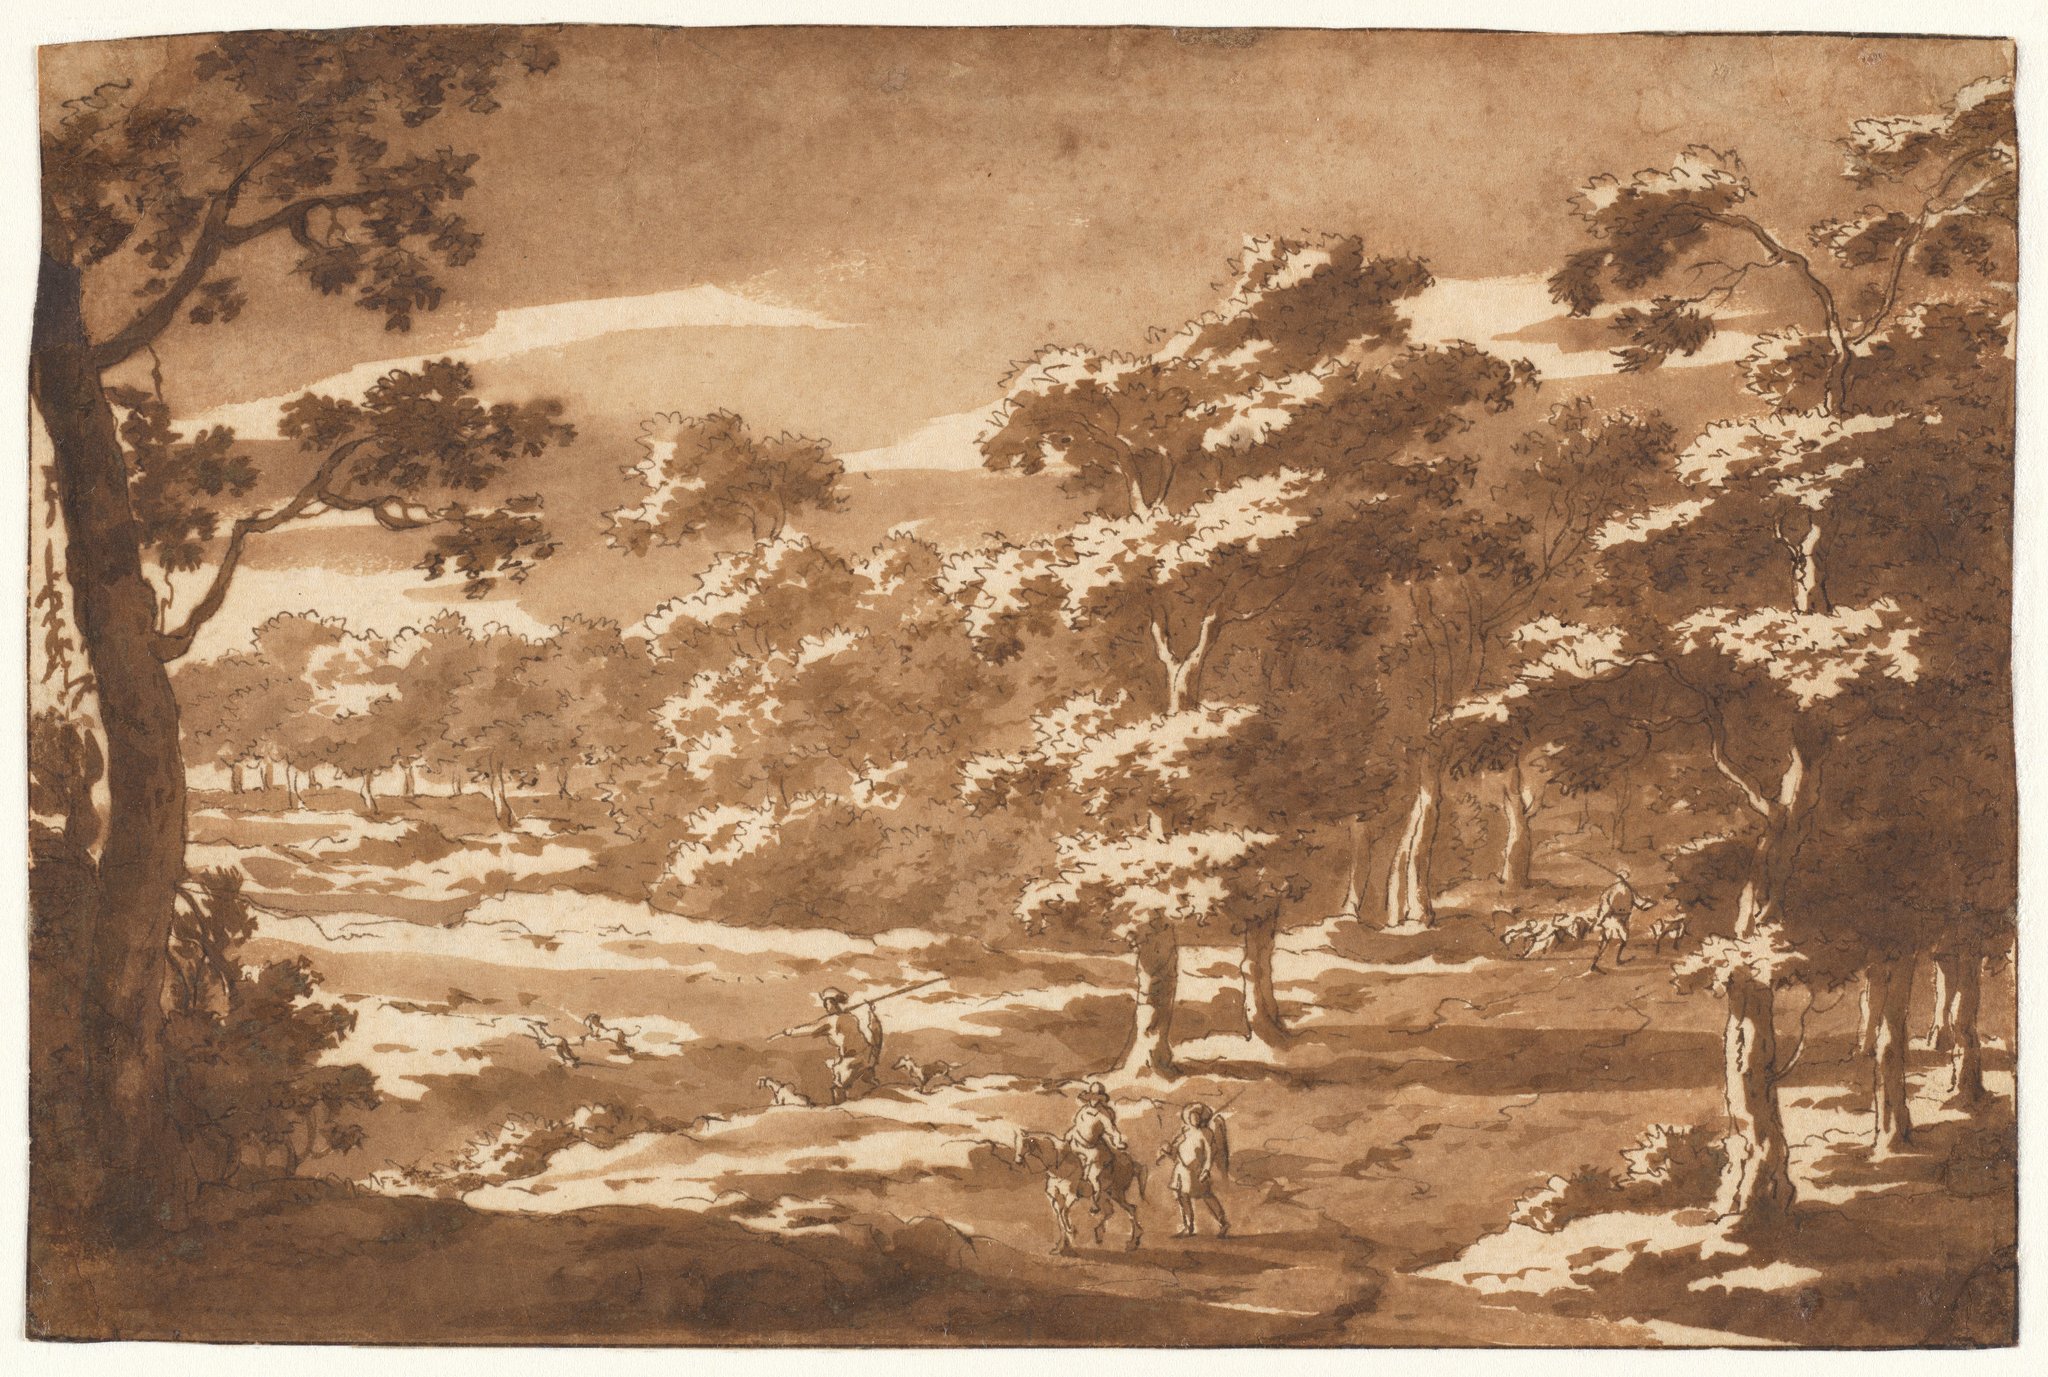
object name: drawing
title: Forest Clearing with Figures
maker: jan frans van bloemen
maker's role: artist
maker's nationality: flemish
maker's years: 1662-1749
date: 1700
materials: ink, paper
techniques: backing, pen, wash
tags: landscapes